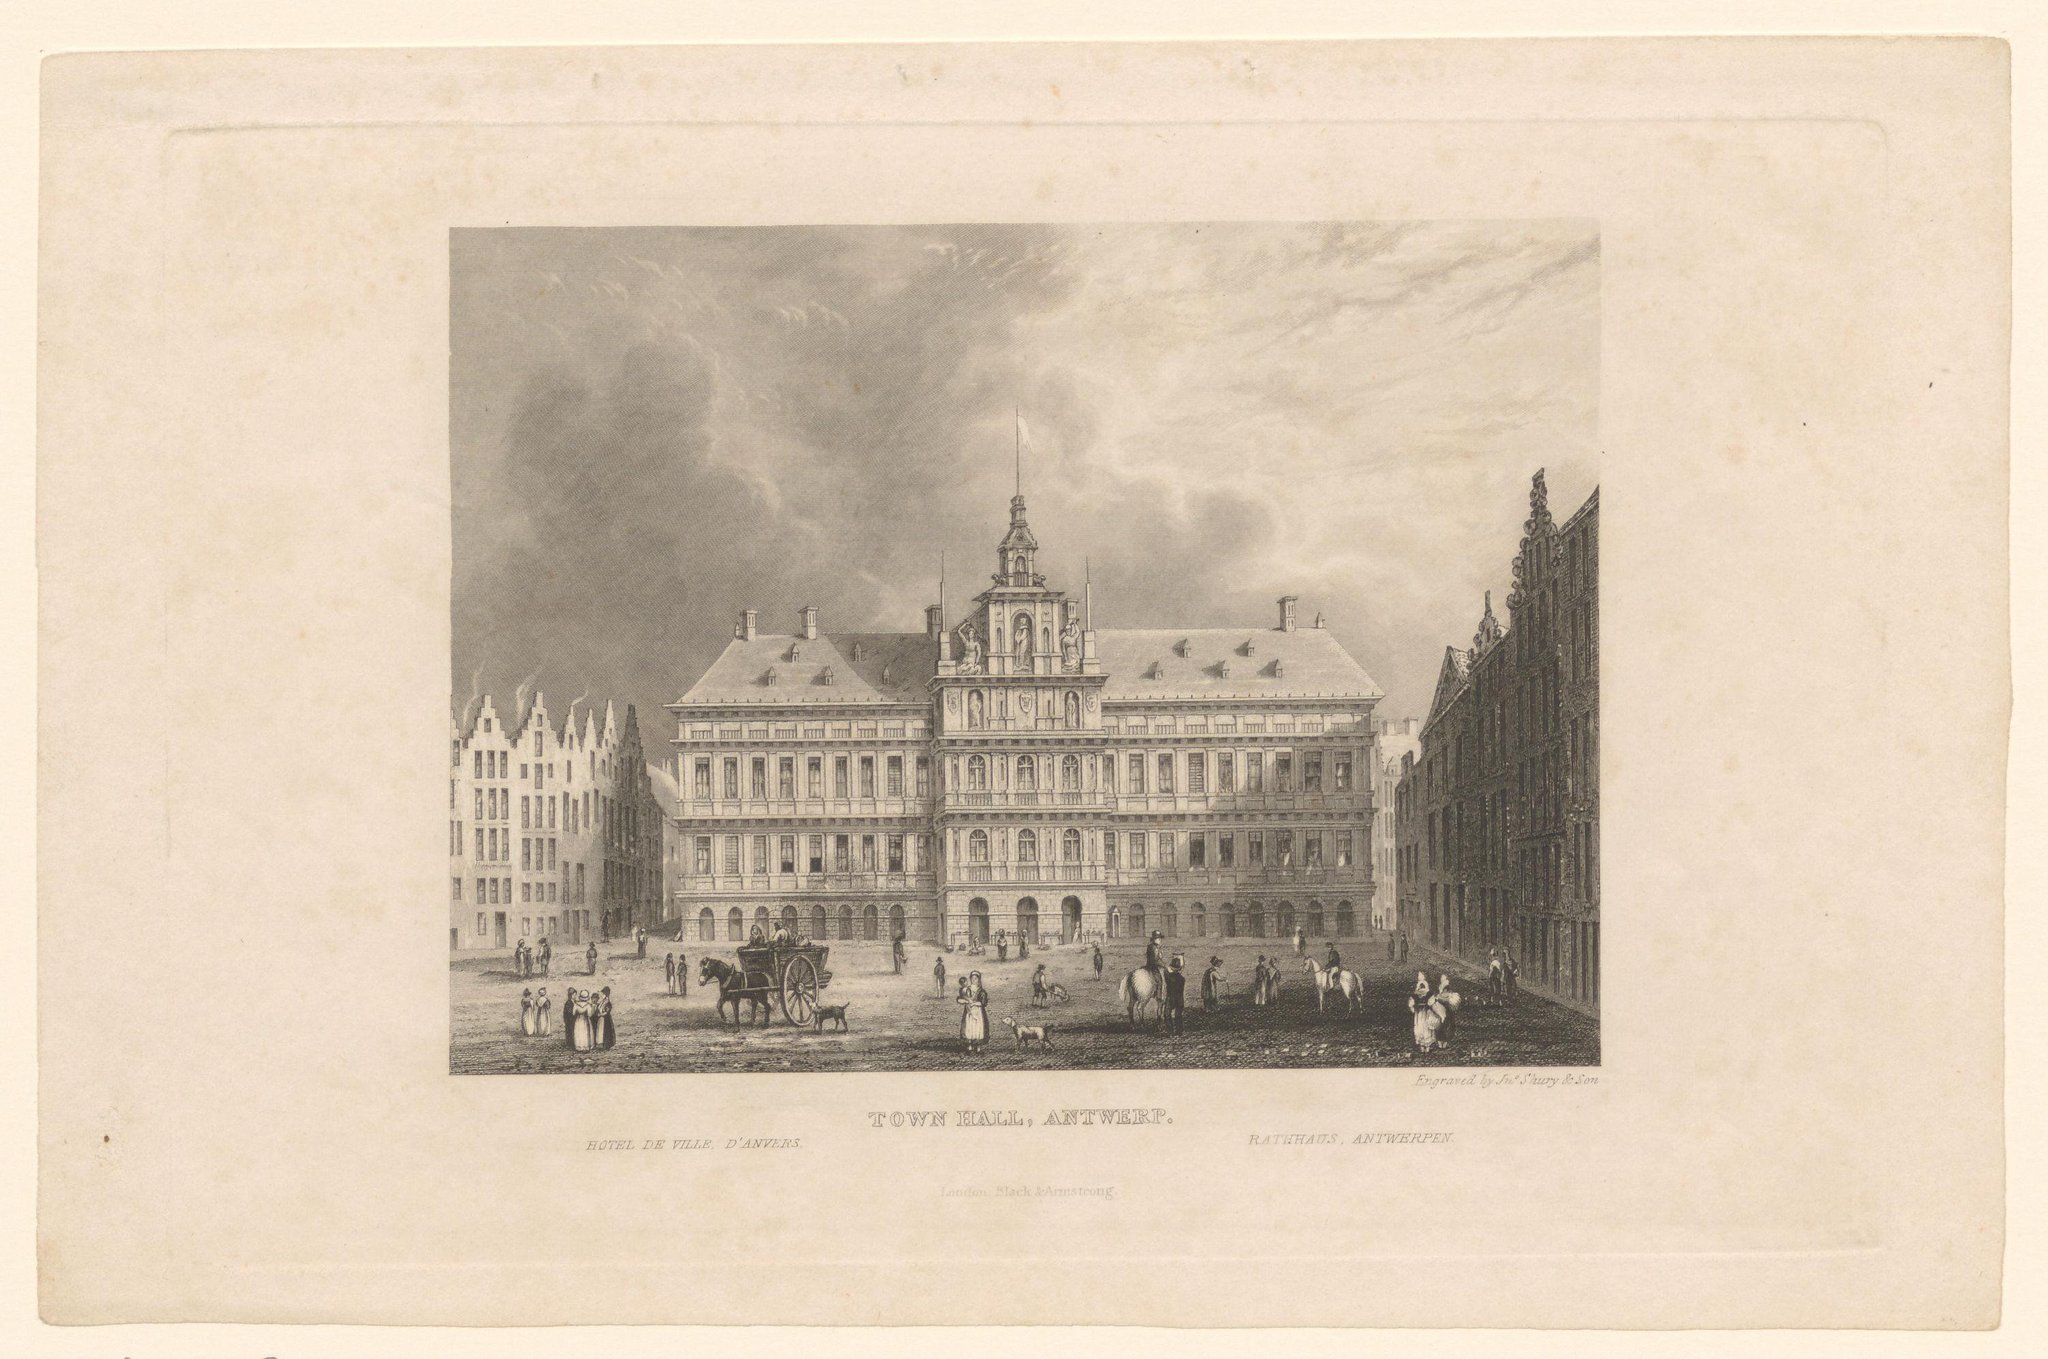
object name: book illustration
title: Town Hall, Antwerp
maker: john shury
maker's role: print maker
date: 1838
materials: paper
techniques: etching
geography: london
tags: townhall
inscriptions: collector's mark: Lugt 2233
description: Prent uit: Belgium and Nassau; or, The continental Tourist. Londen: Black & Armstrong, 1838.